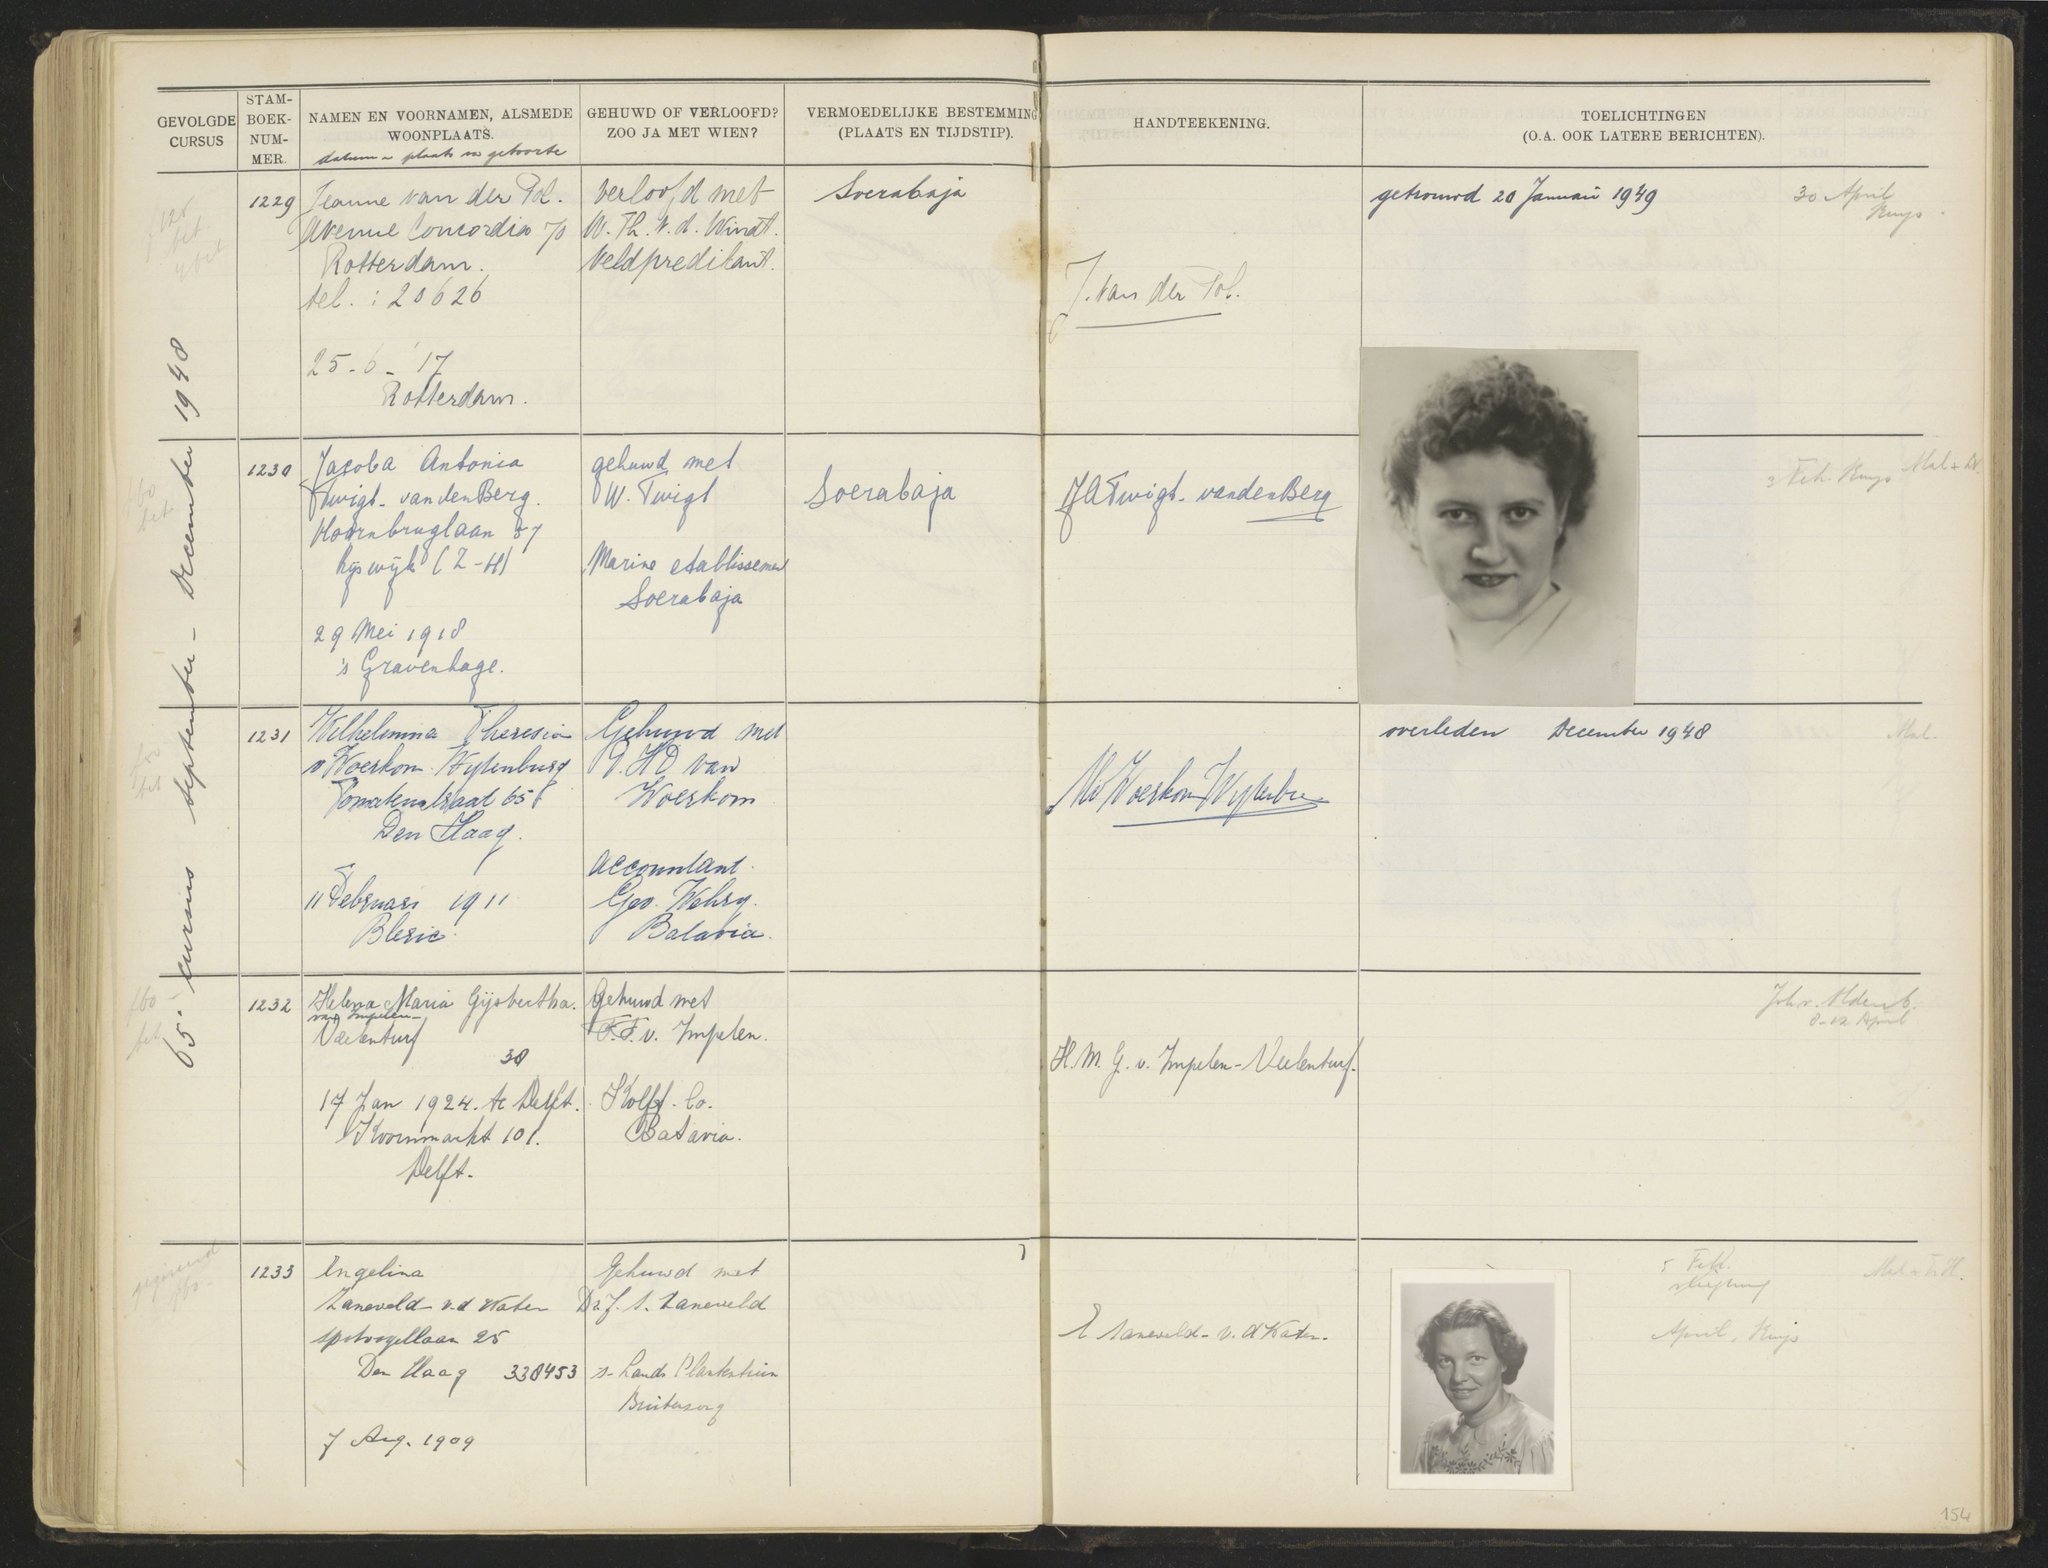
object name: album leaf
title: Blad 154 uit Stamboek van de leerlingen der Koloniale School voor Meisjes en Vrouwen te 's-Gravenhage deel II (1930-1949)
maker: Anonymous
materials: paper, photographic support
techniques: photography, printing, writing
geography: the hague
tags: further education (+ pupil), further education, the hague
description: Twee pagina's met gegevens van de deelnemers aan de 65e driemaandelijkse cursus van september tot december 1948, stamboeknummers 1229 tot en met 1233. Onderdeel van Stamboek van de leerlingen der Koloniale School voor Meisjes en Vrouwen te 's-Gravenhage deel II (1930-1949).